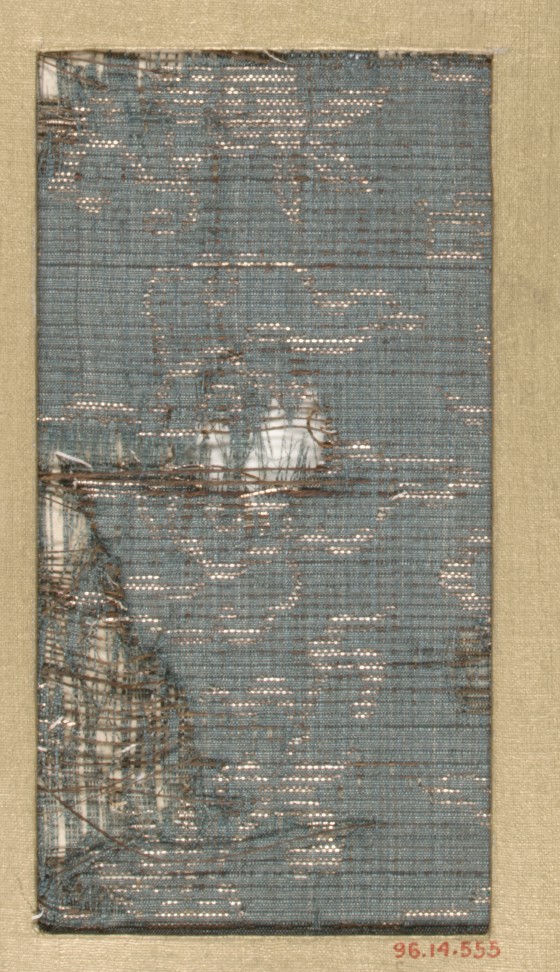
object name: piece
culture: japanese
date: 1701-1900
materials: silk